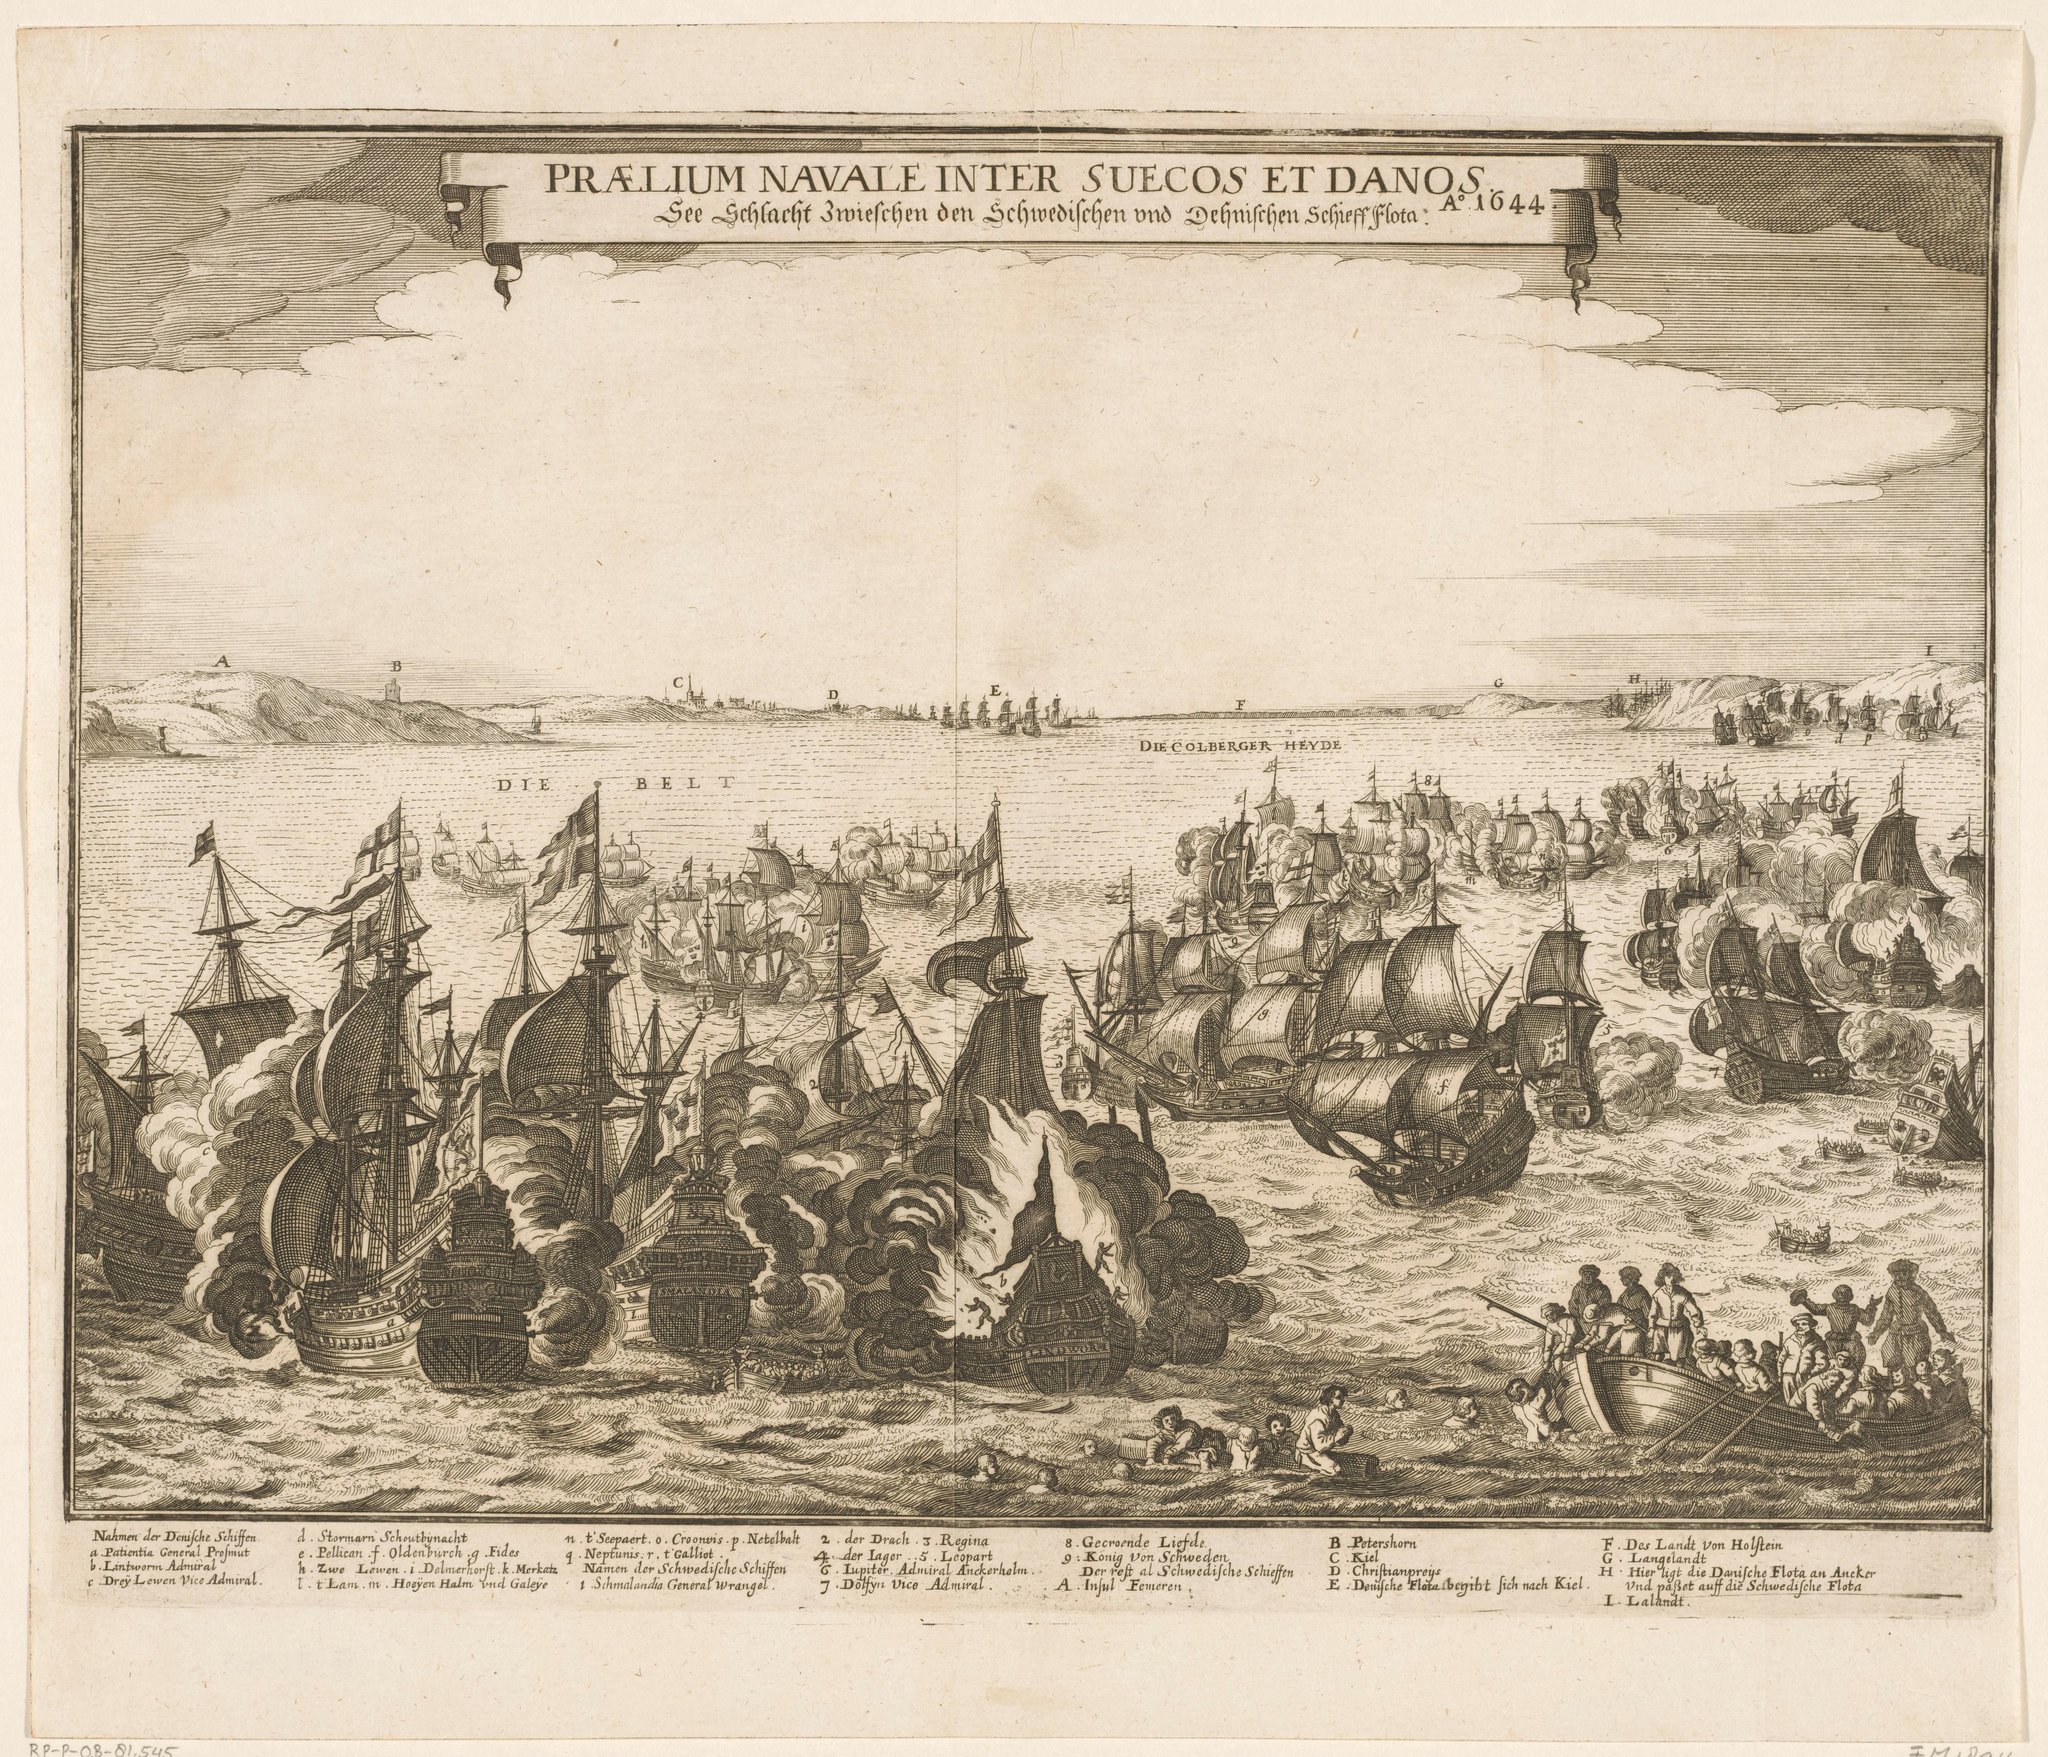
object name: print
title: Zeeslag tussen de Zweedse en Deense vloten in de Belt, 1644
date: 1644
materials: paper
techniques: etching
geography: germany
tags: flushing, battle (+ naval force)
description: Zeeslag tussen de Zweedse en Deense vloten in de Fehmarn Belt (tussen het Deense Lolland en het Duitse eiland Fehmarn), 23 oktober 1644. De Zweden worden bijgestaan door een Nederlandse vloot onder Maerten Thijssen Anckerhelm. Zeeslag in volle gang, centraal het brandende Deense schip de Lindeworm, op de voorgrond drenkelingen in een sloep. In het onderschrift de legenda's a-r en 1-9 en A-I in het Duits. Bij de prent behoort ook een kaart met de locatie van de zeeslag.